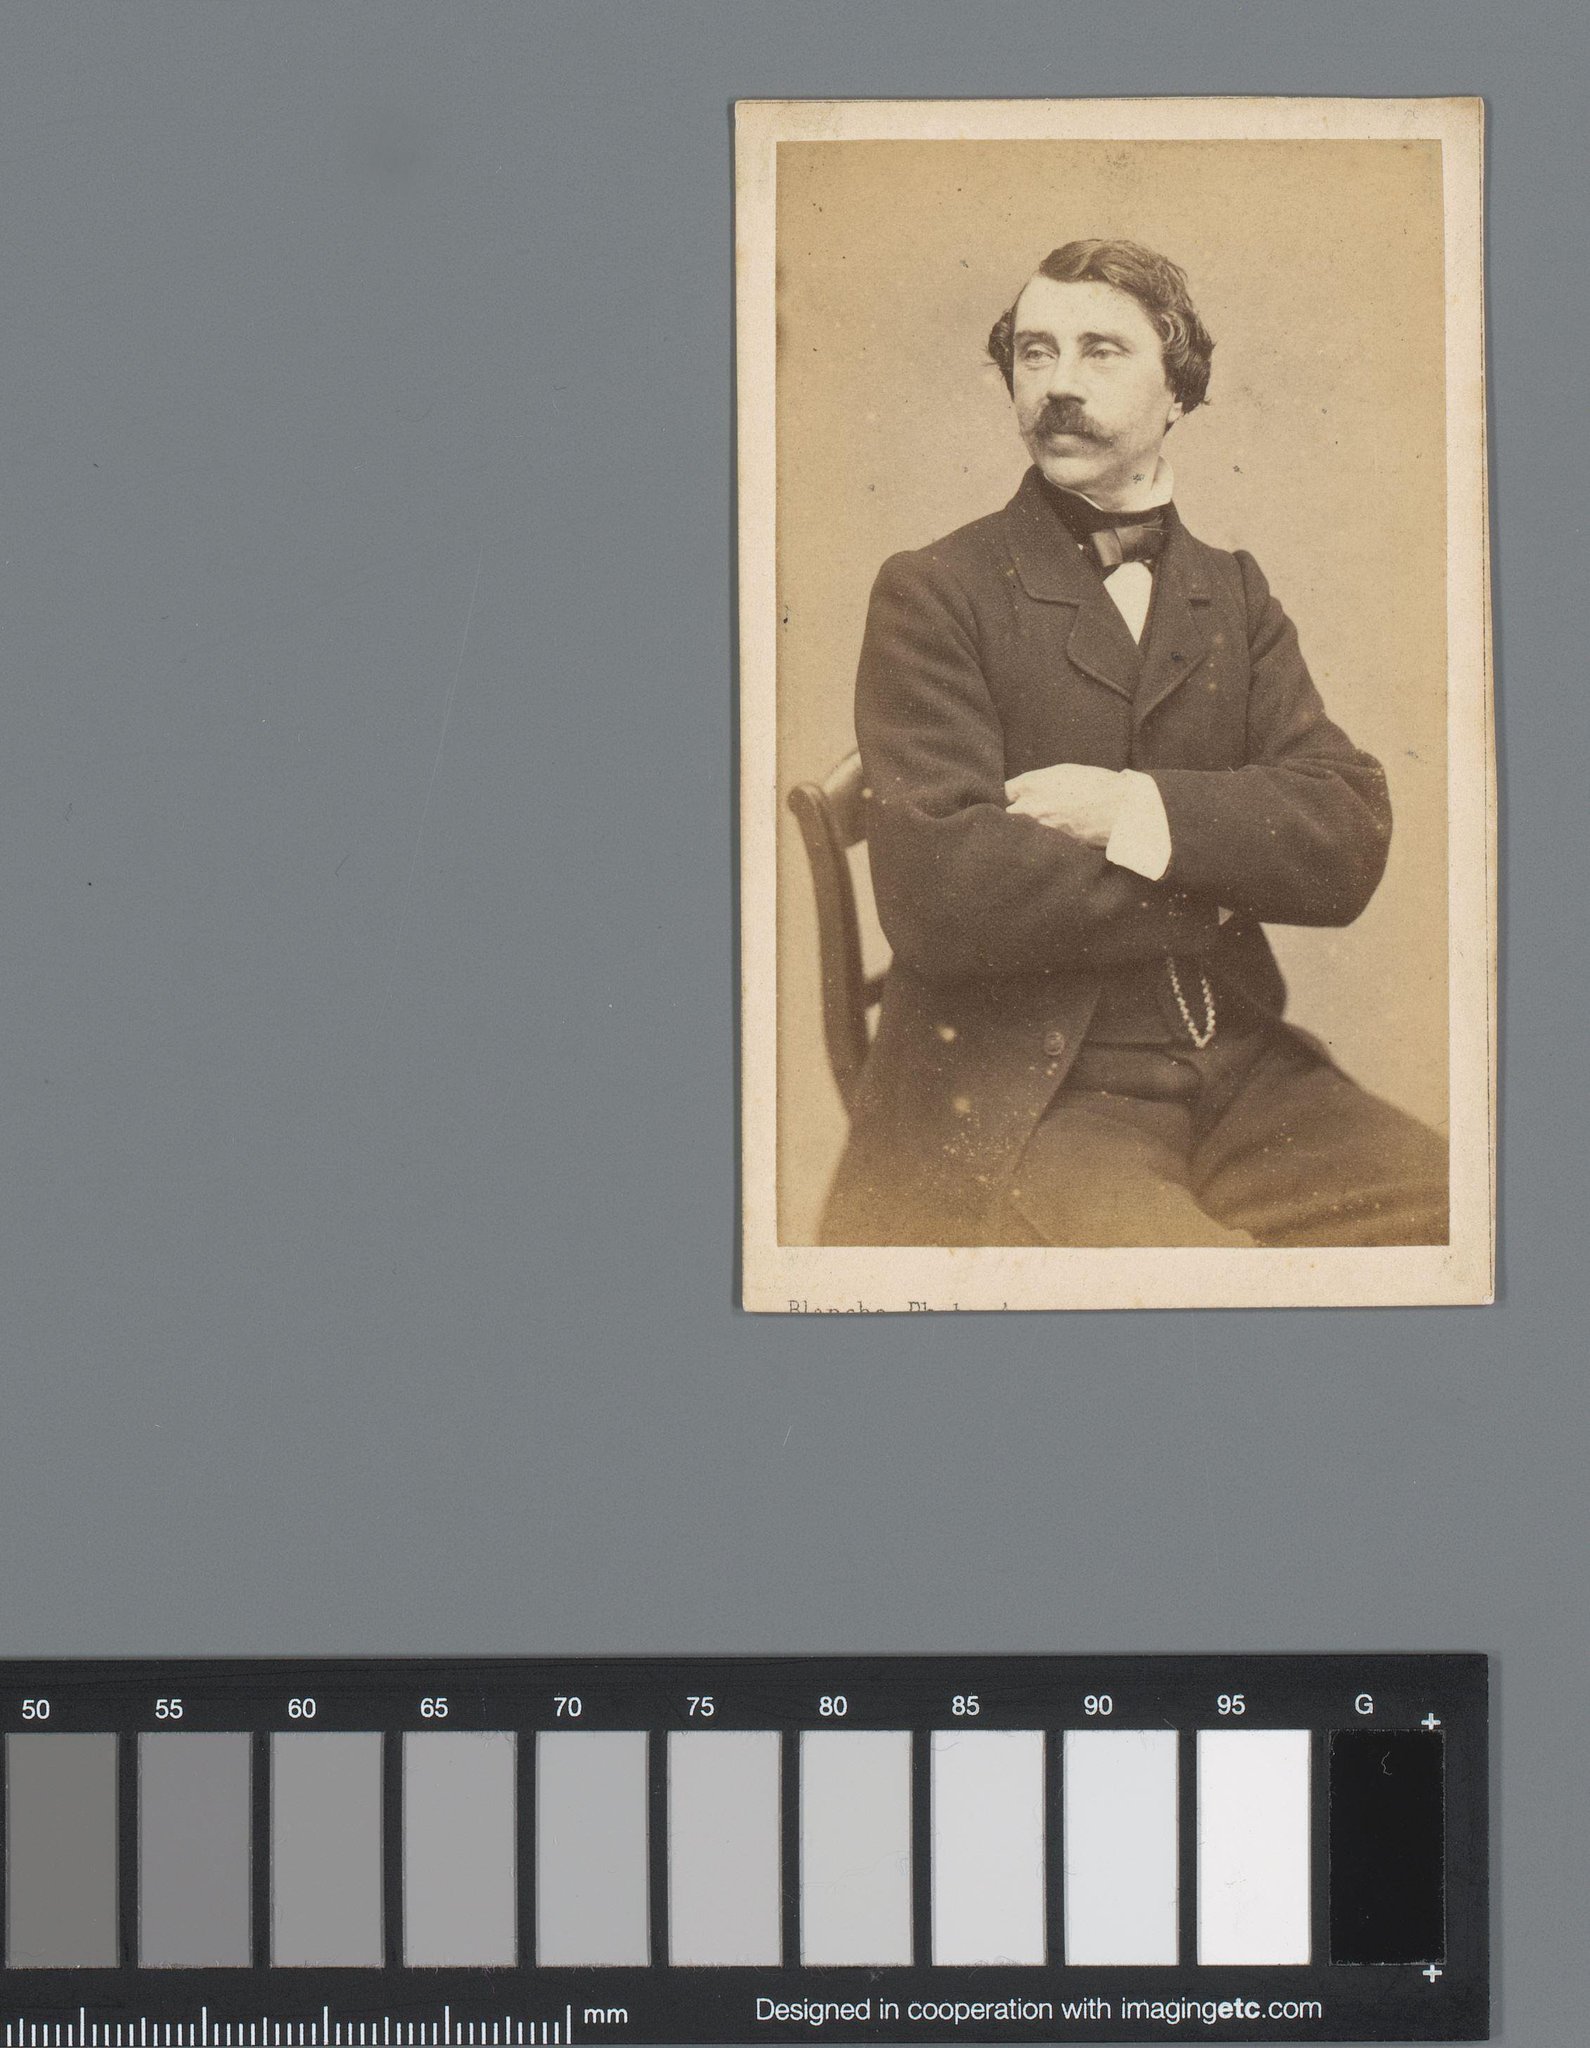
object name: carte de visite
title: Portret van de schilder Josef Cornelius Correns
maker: auguste blanche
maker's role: fotograaf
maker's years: 1818-1866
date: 1865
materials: cardboard, paper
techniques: albumen print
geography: antwerp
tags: antwerp, painter, draughtsman, jozef cornelius correns, historical persons, portrait, self-portrait of painter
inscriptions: inscription: ‘Joseph?/ 1814/ Correns (peintre)/ 1865.’, inscription: ‘Blanche/ Photographe,/ Rue des Aveugles/ & Place du Musée/ Anvers/ D.W.124.’